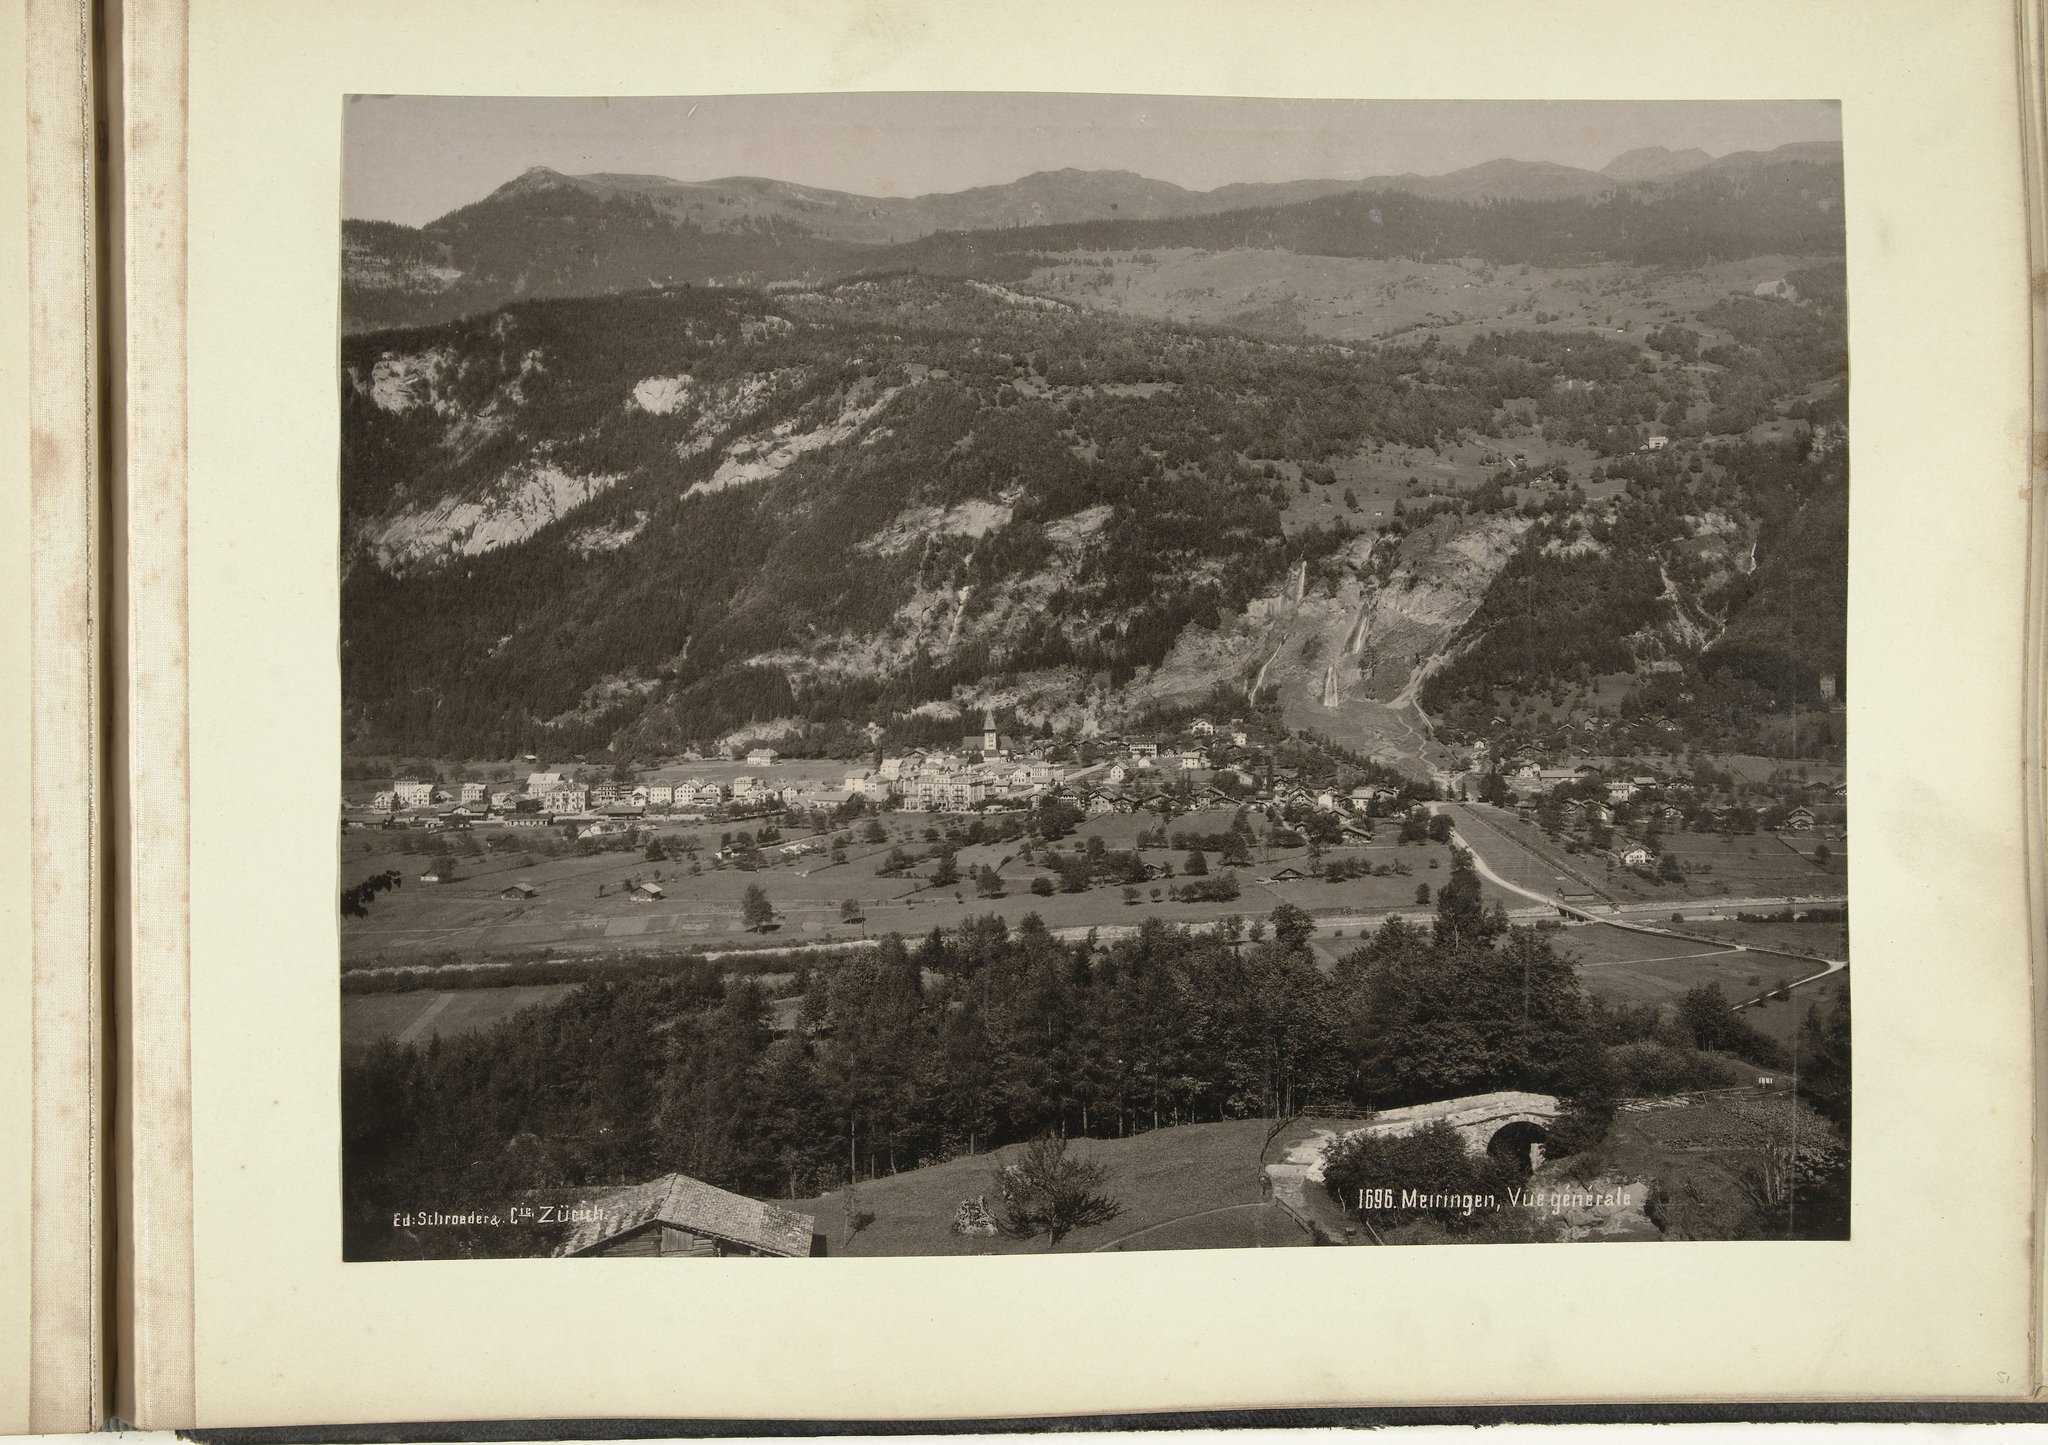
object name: album leaf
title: Meiringen, Vue Generale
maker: Anonymous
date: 1892-1895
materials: paper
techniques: photograph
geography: meiringen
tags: dale, valley, city-view in general; 'veduta'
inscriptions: number: ‘1696.’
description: In 1891 brandde de dorpskern van Meiringen af. Deze afbeelding toont het nieuwe stratenplan. De Aarebrücke rechts werd in 1896 vervangen door een ijzeren brug.